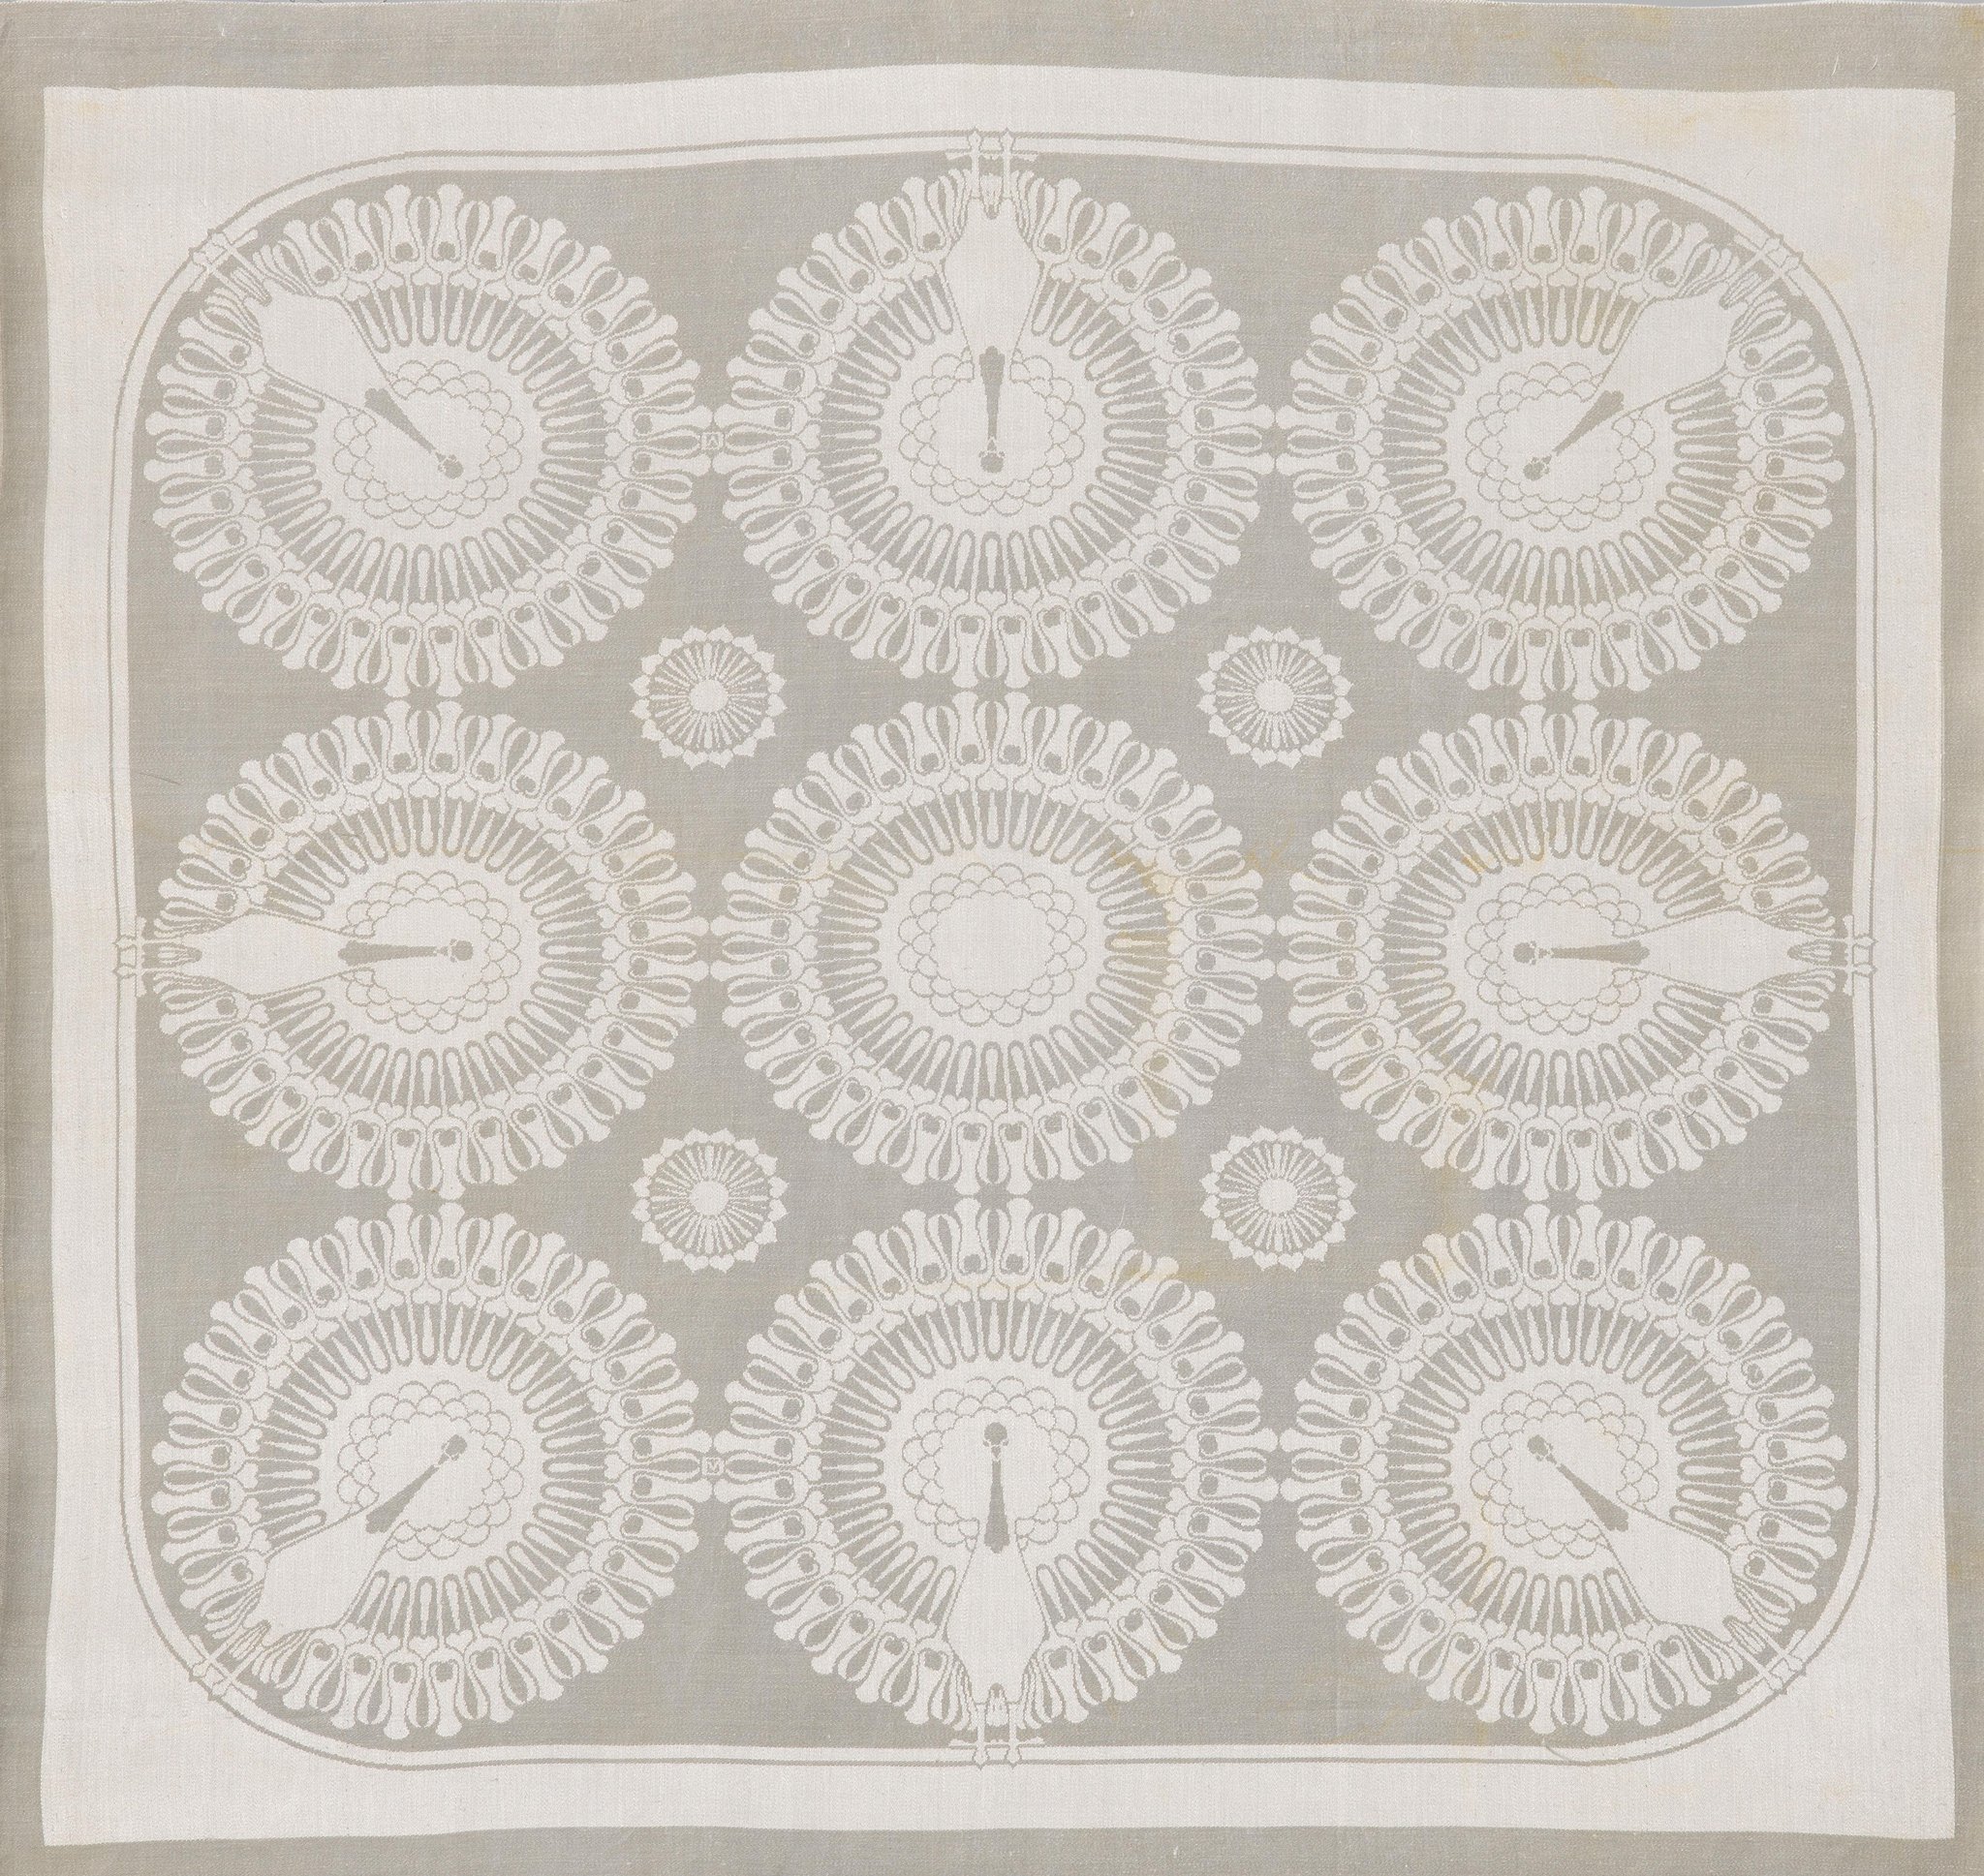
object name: napkin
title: Servet met het dessin "Pauw"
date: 1918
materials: linen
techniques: damask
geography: eindhoven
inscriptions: factory mark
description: Servet van linnendamast met het dessin "Pauw" (dessin 526). Bidden een gladde lijst met afgeronde hoeken staan negen cirkels. De buitenste vertonen een naar binnen gekeerde pauw. De pauw is frontaal gezien en in pronkhouding. De middelste cirkel heeft uistluitend de gestileerde pauwenstaart. Vier kleine rozetten als tussenvulling. Ongezoomd.